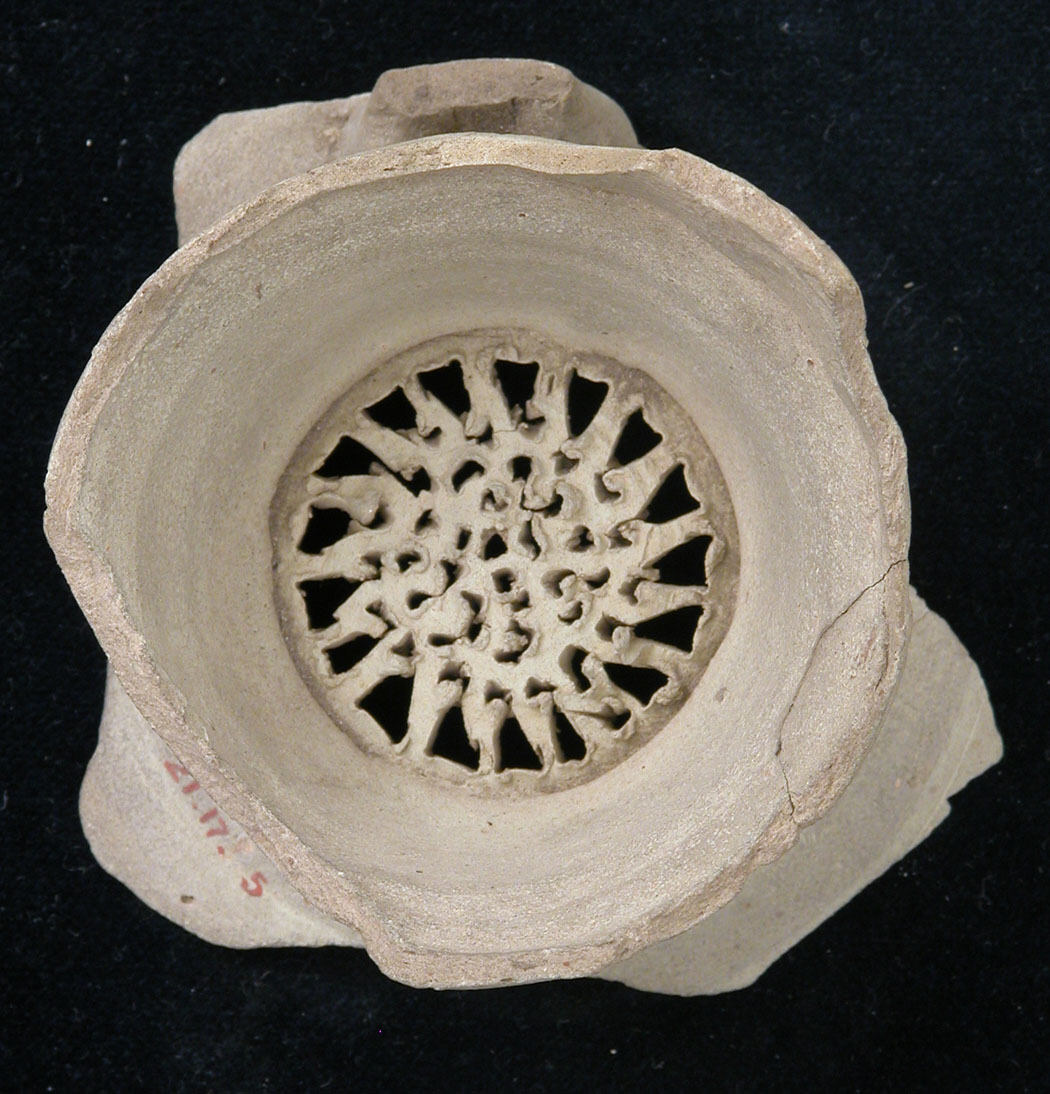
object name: water filter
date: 901-1200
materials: earthenware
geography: egypt